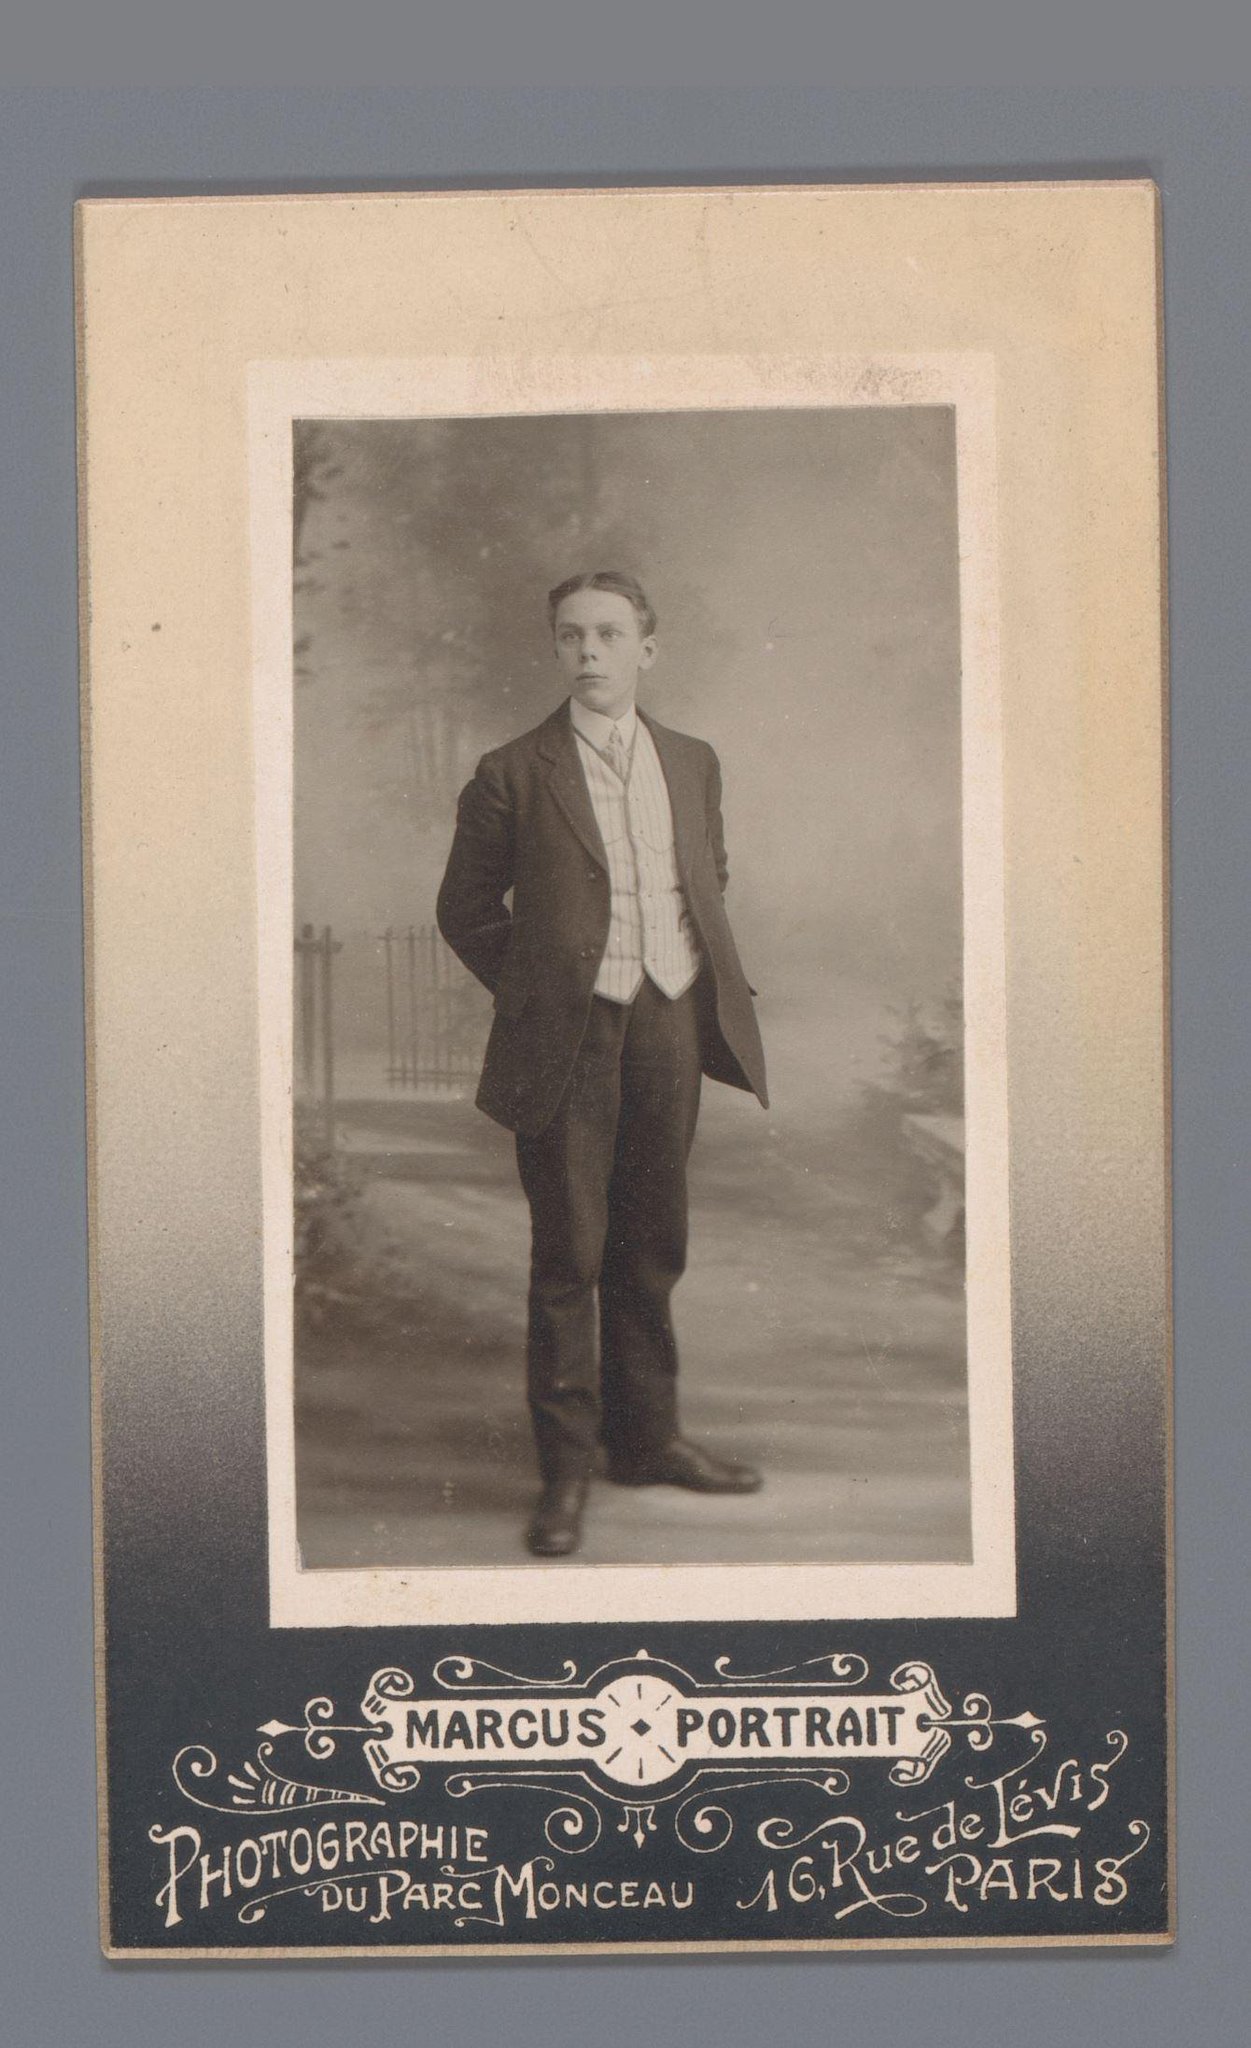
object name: carte de visite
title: Portret van een onbekende man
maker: marcus (fotograaf)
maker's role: fotograaf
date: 1900-1920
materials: cardboard, photographic support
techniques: matte daylight collodion silver print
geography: paris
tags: historical persons, youth, adolescent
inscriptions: inscription: ‘MARCUS * PORTRAIT/ PHOTOGRAPHIE/ DU PARC MONCEAU/ 16, Rue de Lévis/ PARIS’